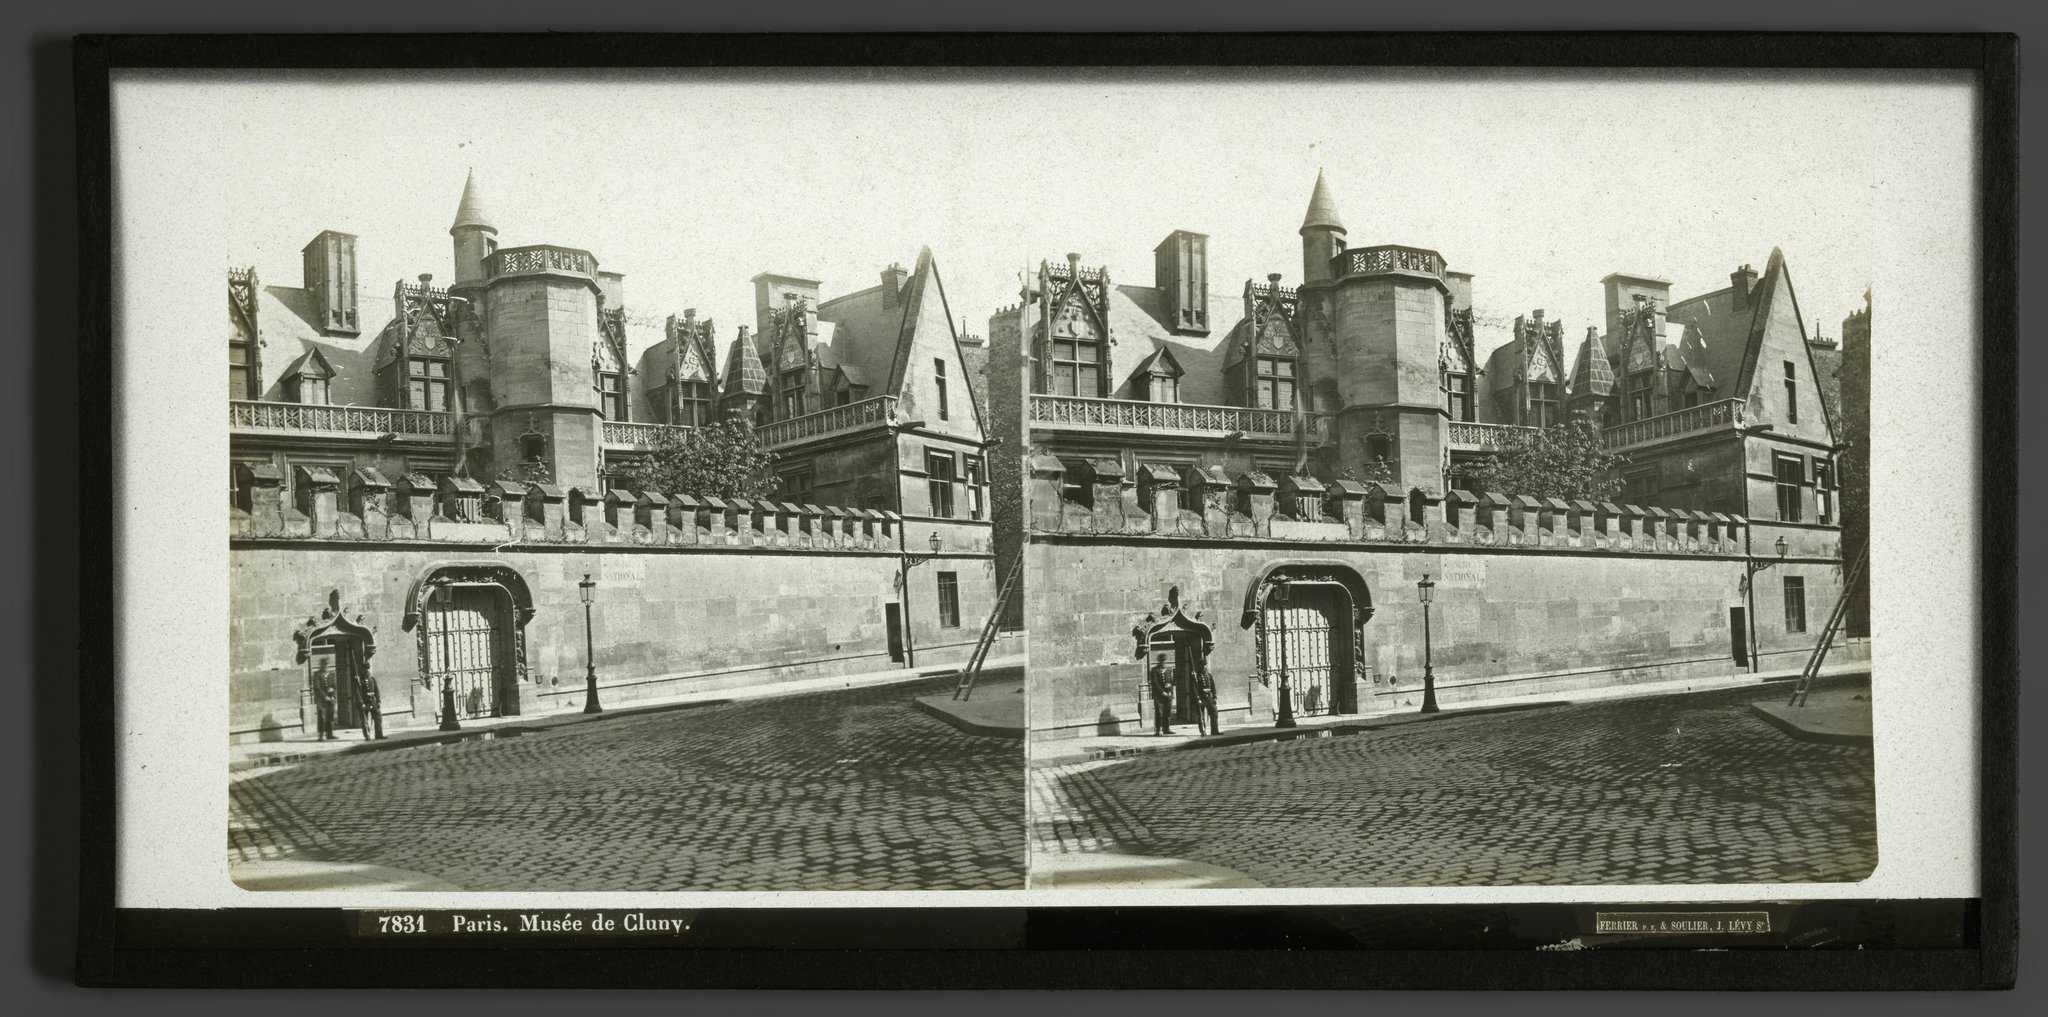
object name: stereoscopic photograph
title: Gezicht op Musée de Cluny in Parijs, Frankrijk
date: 1860-1870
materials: glass, paper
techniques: slide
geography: paris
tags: permanent exhibition, museum, façade (of house or building)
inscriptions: number: ‘7831’